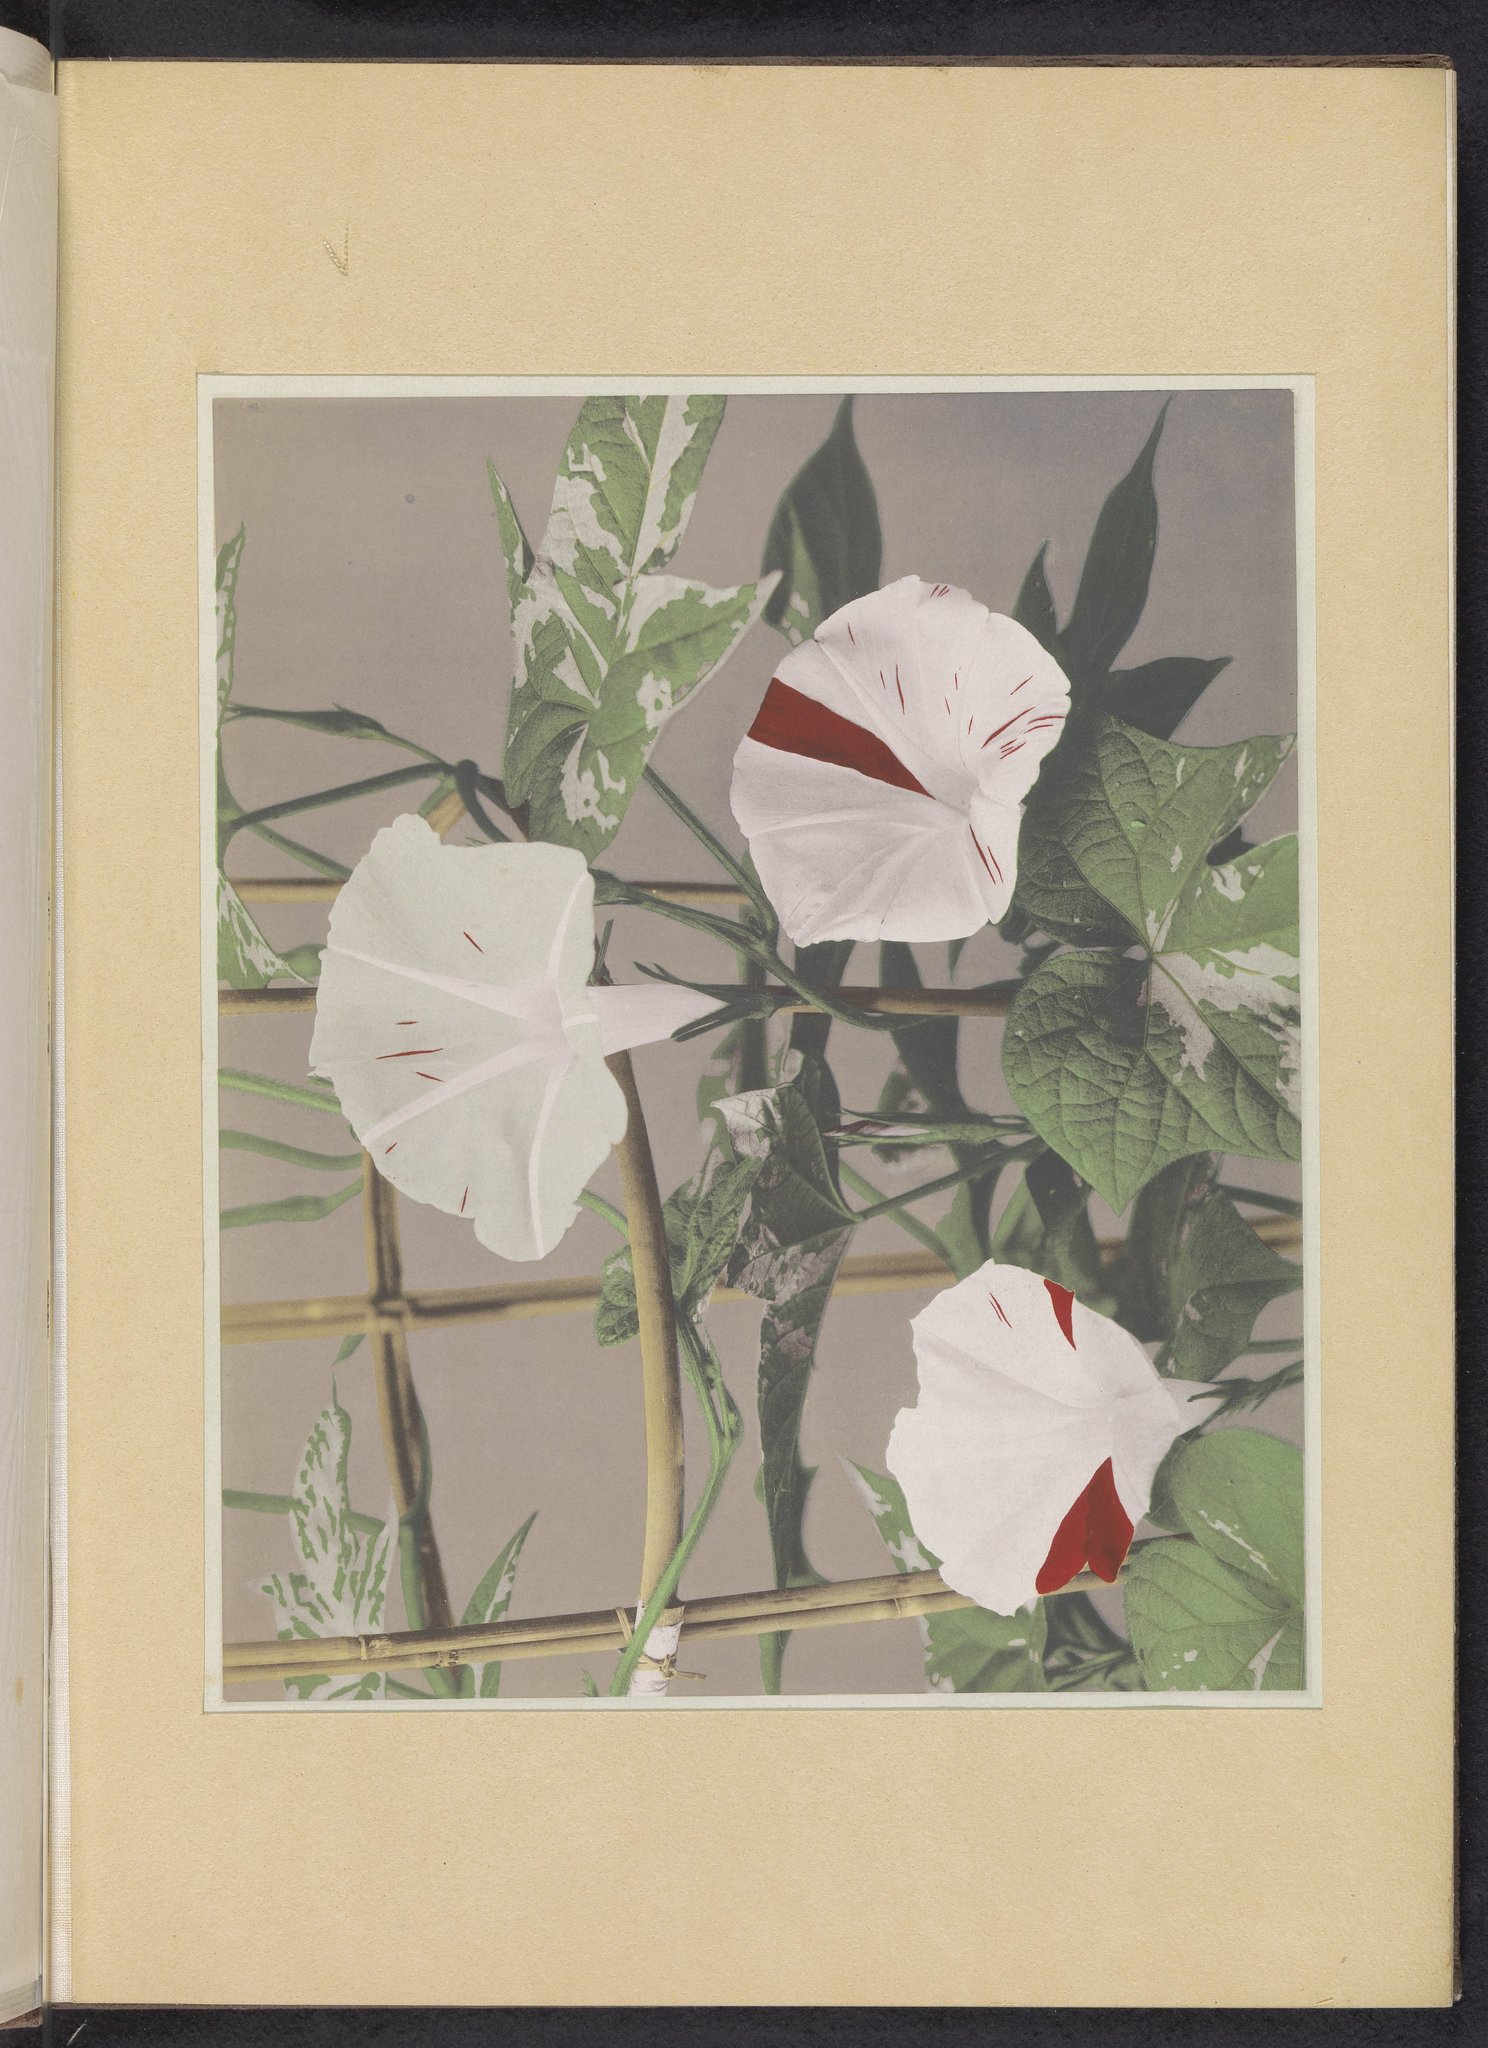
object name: photomechanical print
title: Gestreepte windebloemen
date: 1887-1897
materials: paper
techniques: photograph, hand coloring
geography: japan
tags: flowers